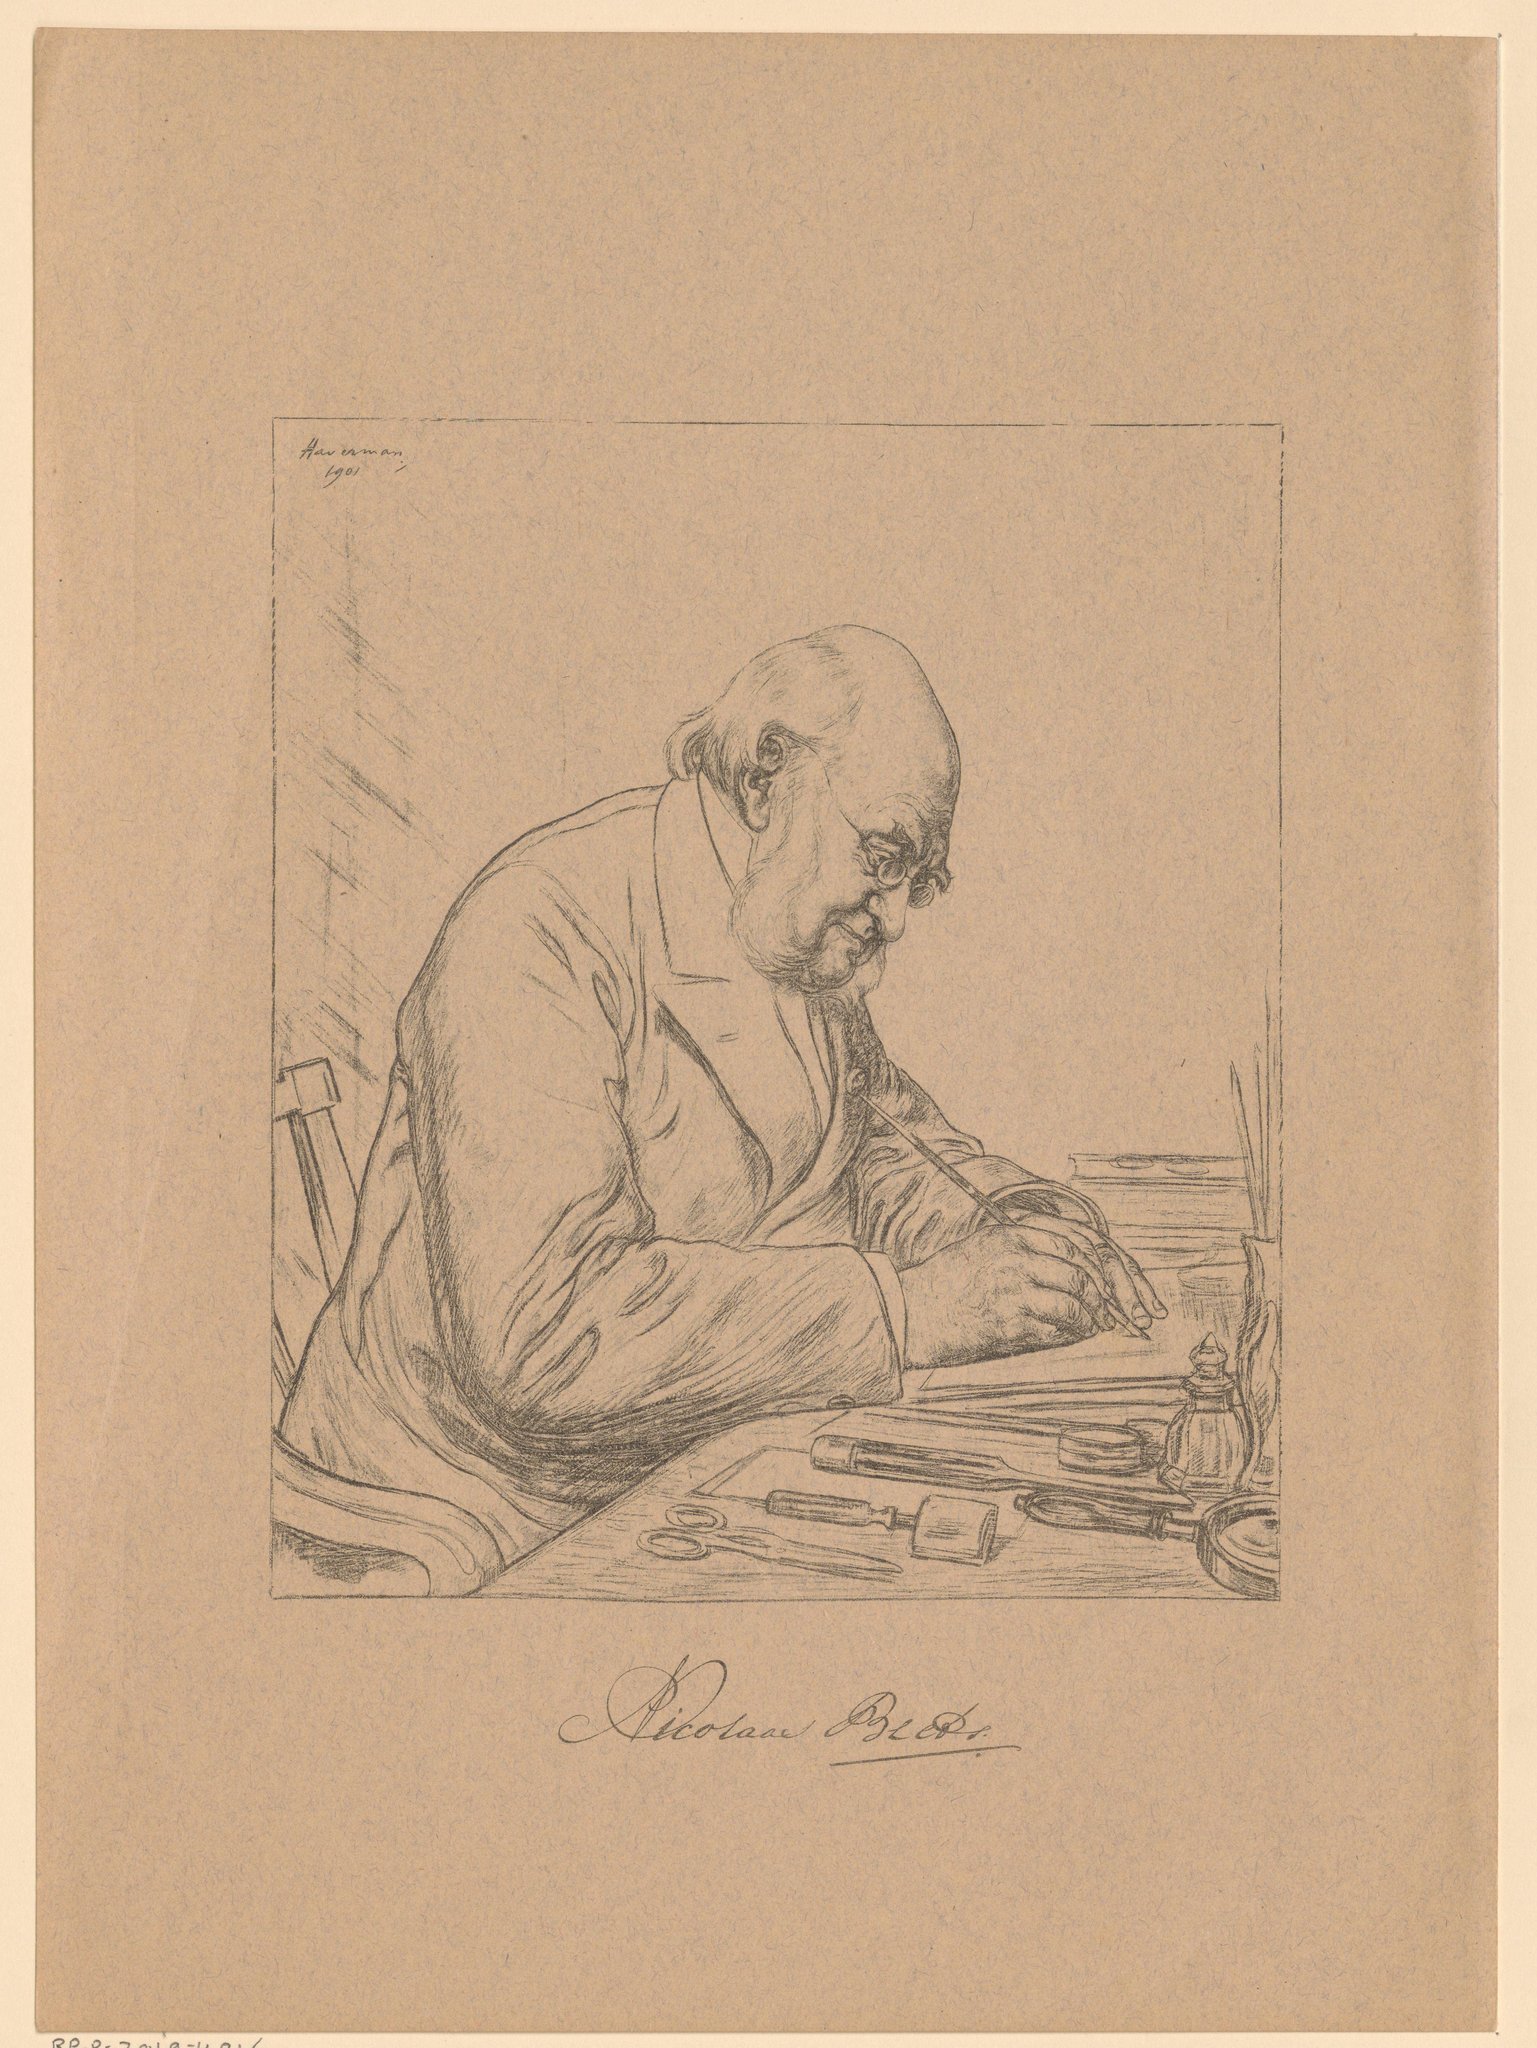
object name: print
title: Portret van Nicolaas Beets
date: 1901-1910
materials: paper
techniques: lithograph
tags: haarlem, utrecht, nicolaas beets, writing-table, writing-desk, historical persons, writer, poet, author